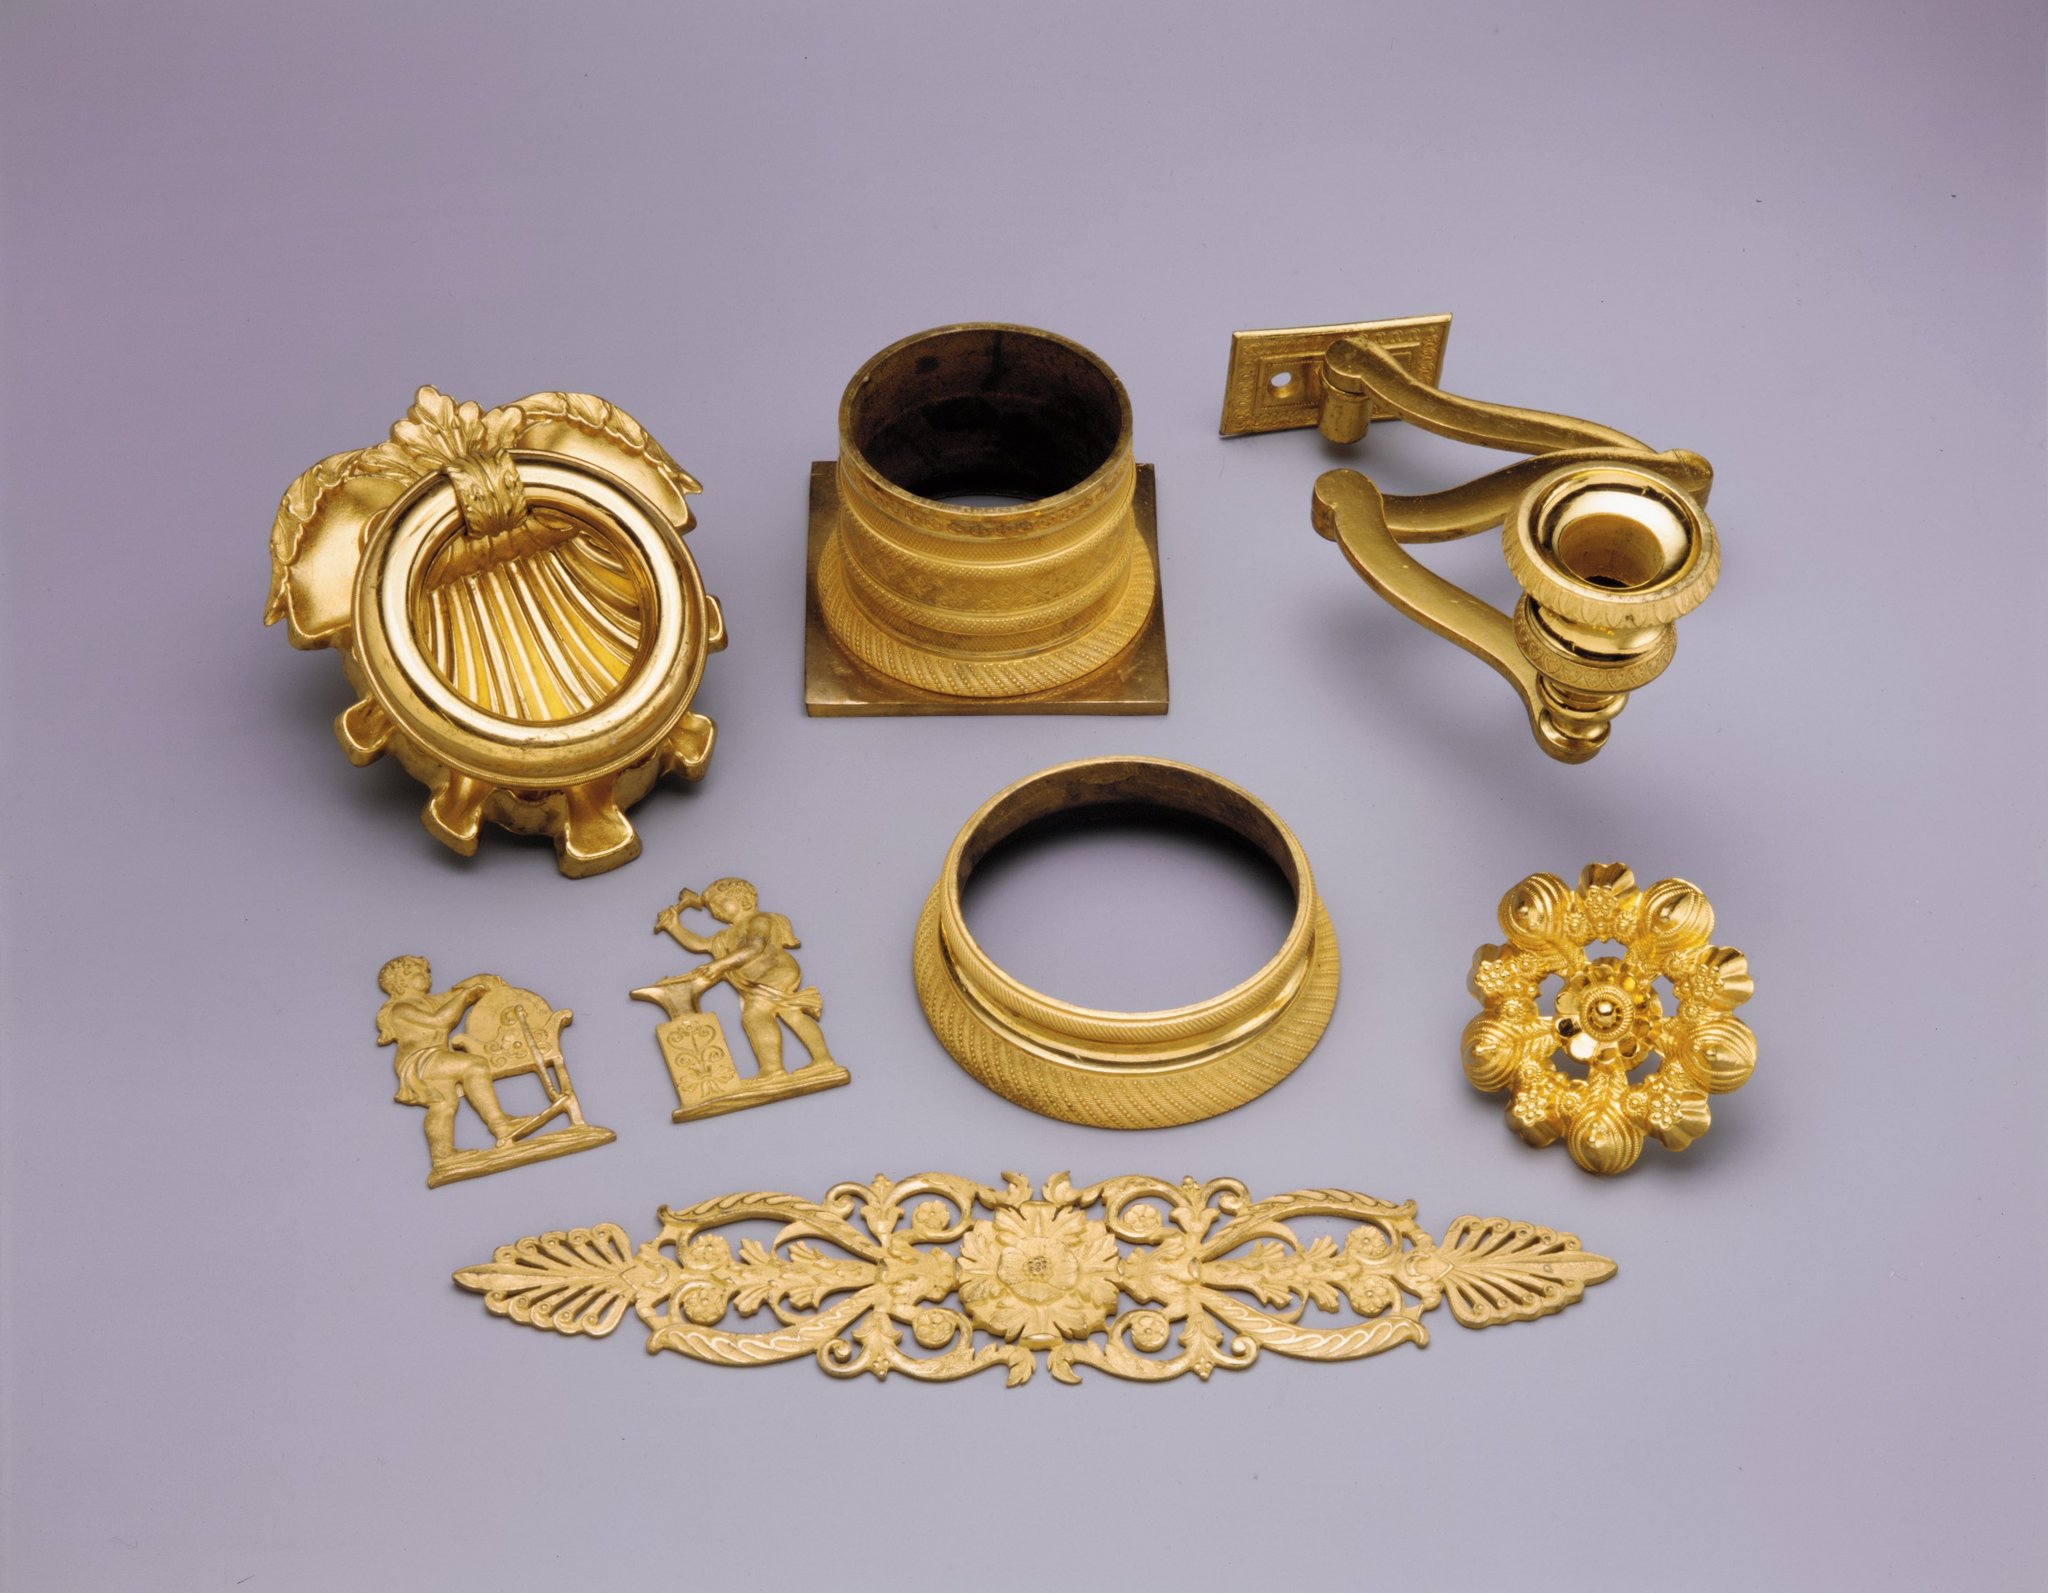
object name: furniture hardware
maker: henry kellam hancock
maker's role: retailer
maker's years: 1816-1851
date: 1820-1830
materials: brass, gilt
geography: france